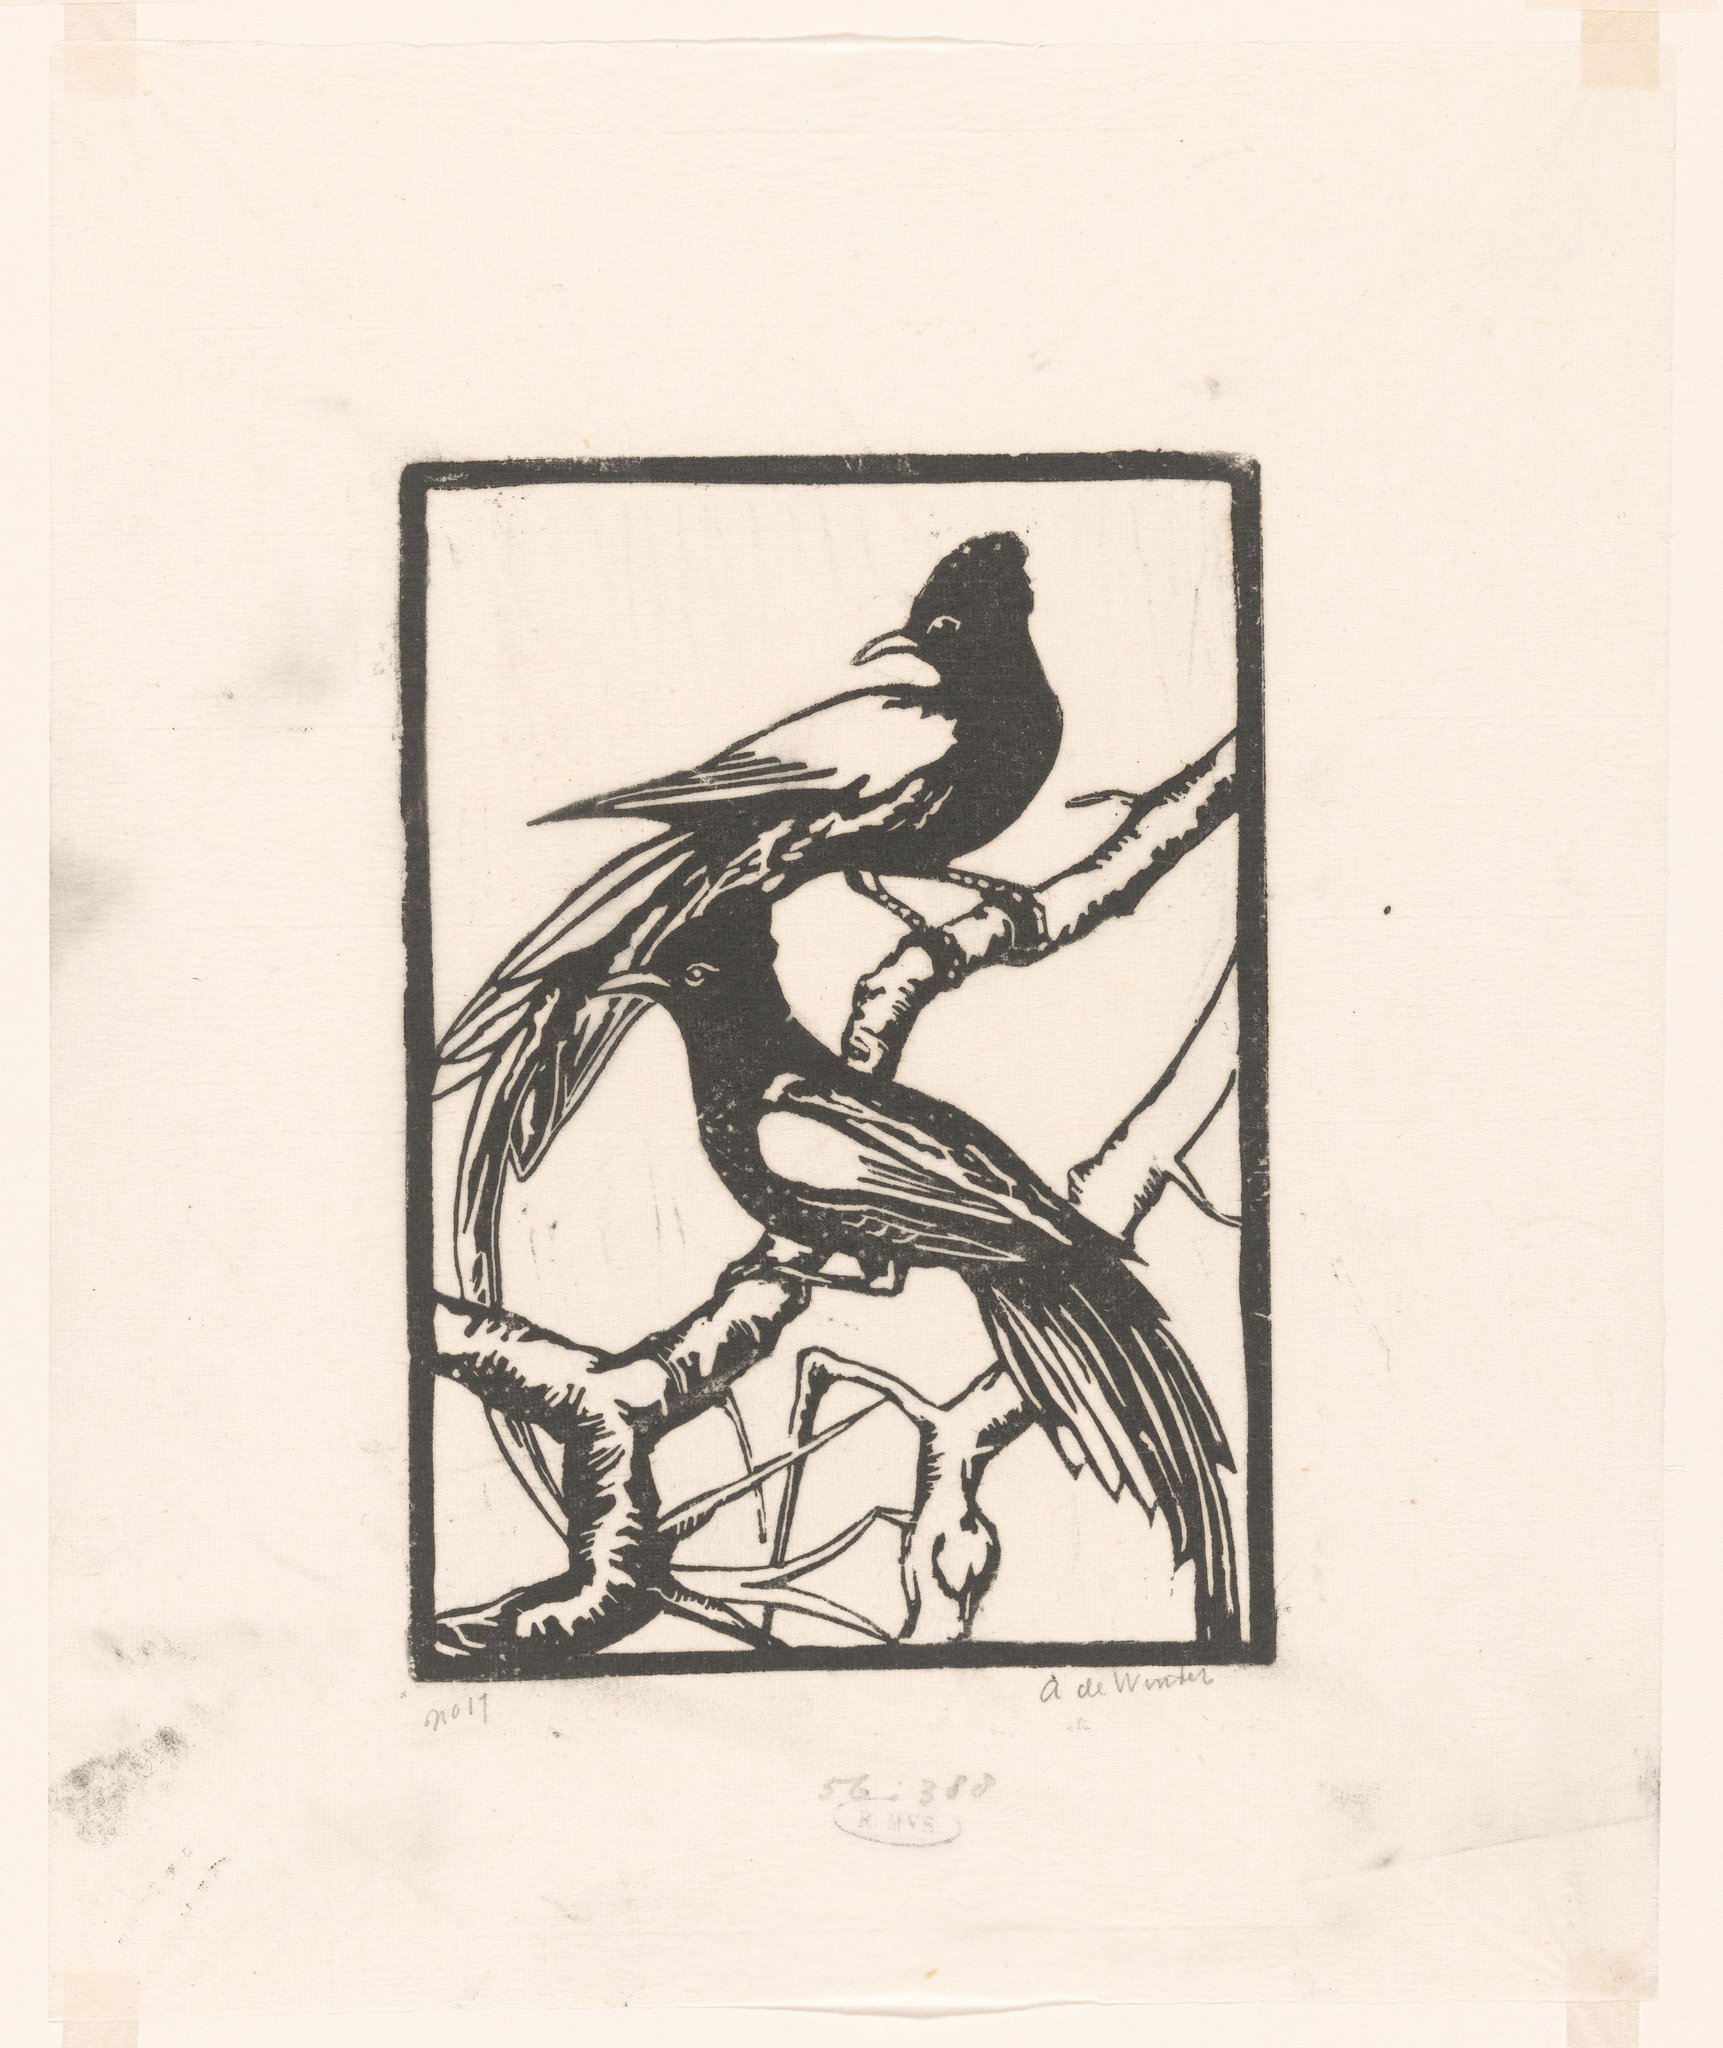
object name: print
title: Twee uitheemse vogels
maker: janus de winter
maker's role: print maker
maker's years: 1882-1951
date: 1892-1951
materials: paper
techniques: linocut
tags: birds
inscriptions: inscription: ‘No 17’, collector's mark: Lugt 2228